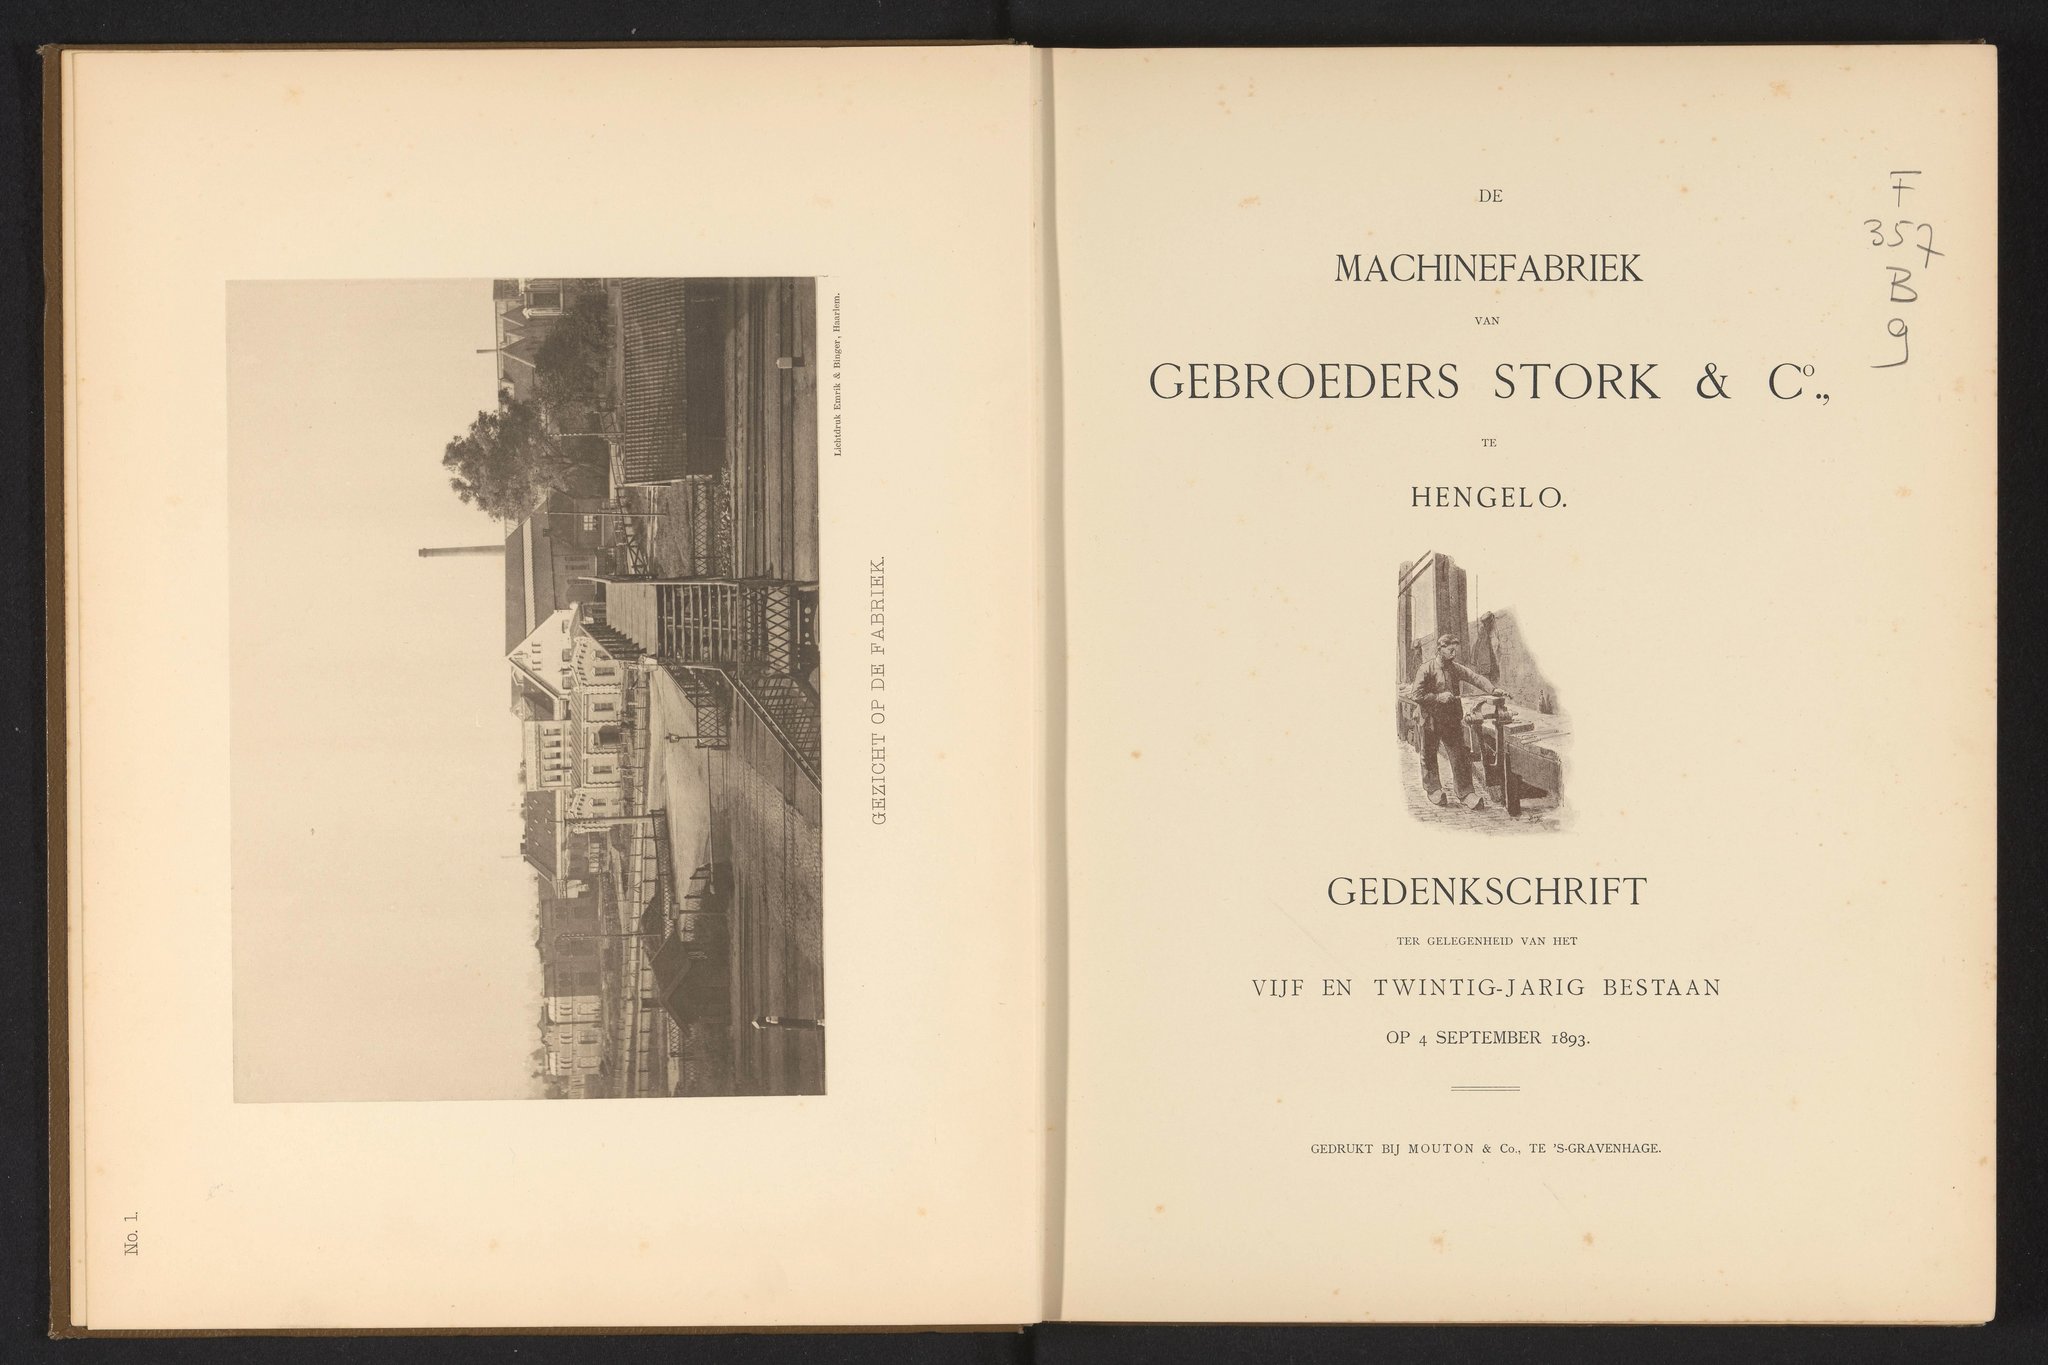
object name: book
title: De machinefabriek van Gebroeders Stork & Co., te Hengelo gedenkschrift ter gelegenheid van het vijf en twintig-jarig bestaan op 4 September 1893.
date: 1894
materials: cardboard, linen, paper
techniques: photograph, decorated paper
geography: the hague